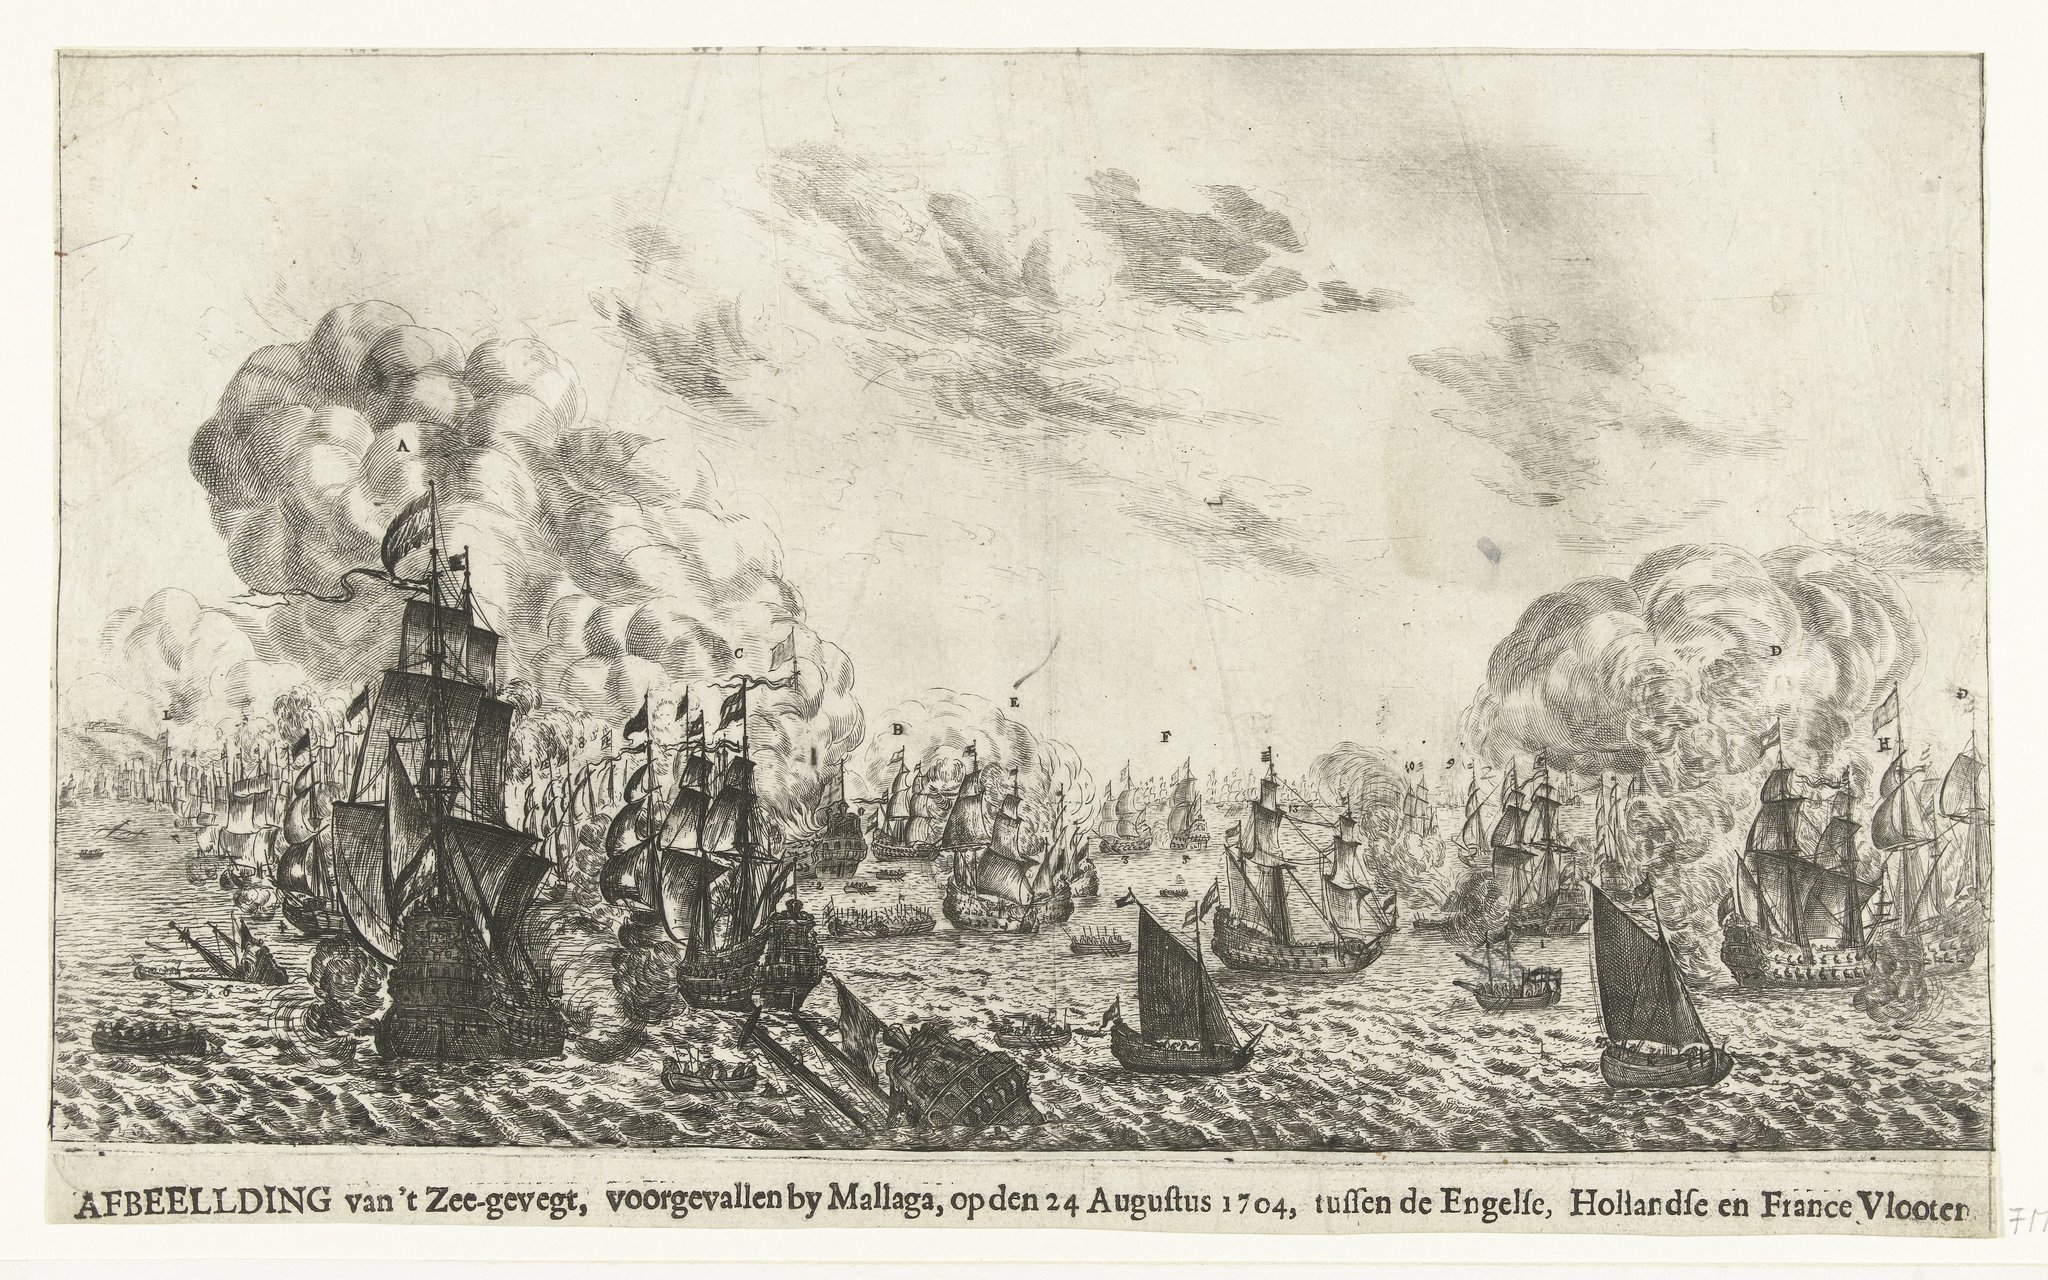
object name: print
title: Zeeslag bij Malaga, 1704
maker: Anonymous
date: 1666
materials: paper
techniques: engraving, etching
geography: northern netherlands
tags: battle (+ naval force)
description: Zeeslag bij Malaga waarbij een gecombineerde Engels-Staatse vloot onder Rooke en Callenburgh de overwinning behaalde op de Fransen, 24 augustus 1704.